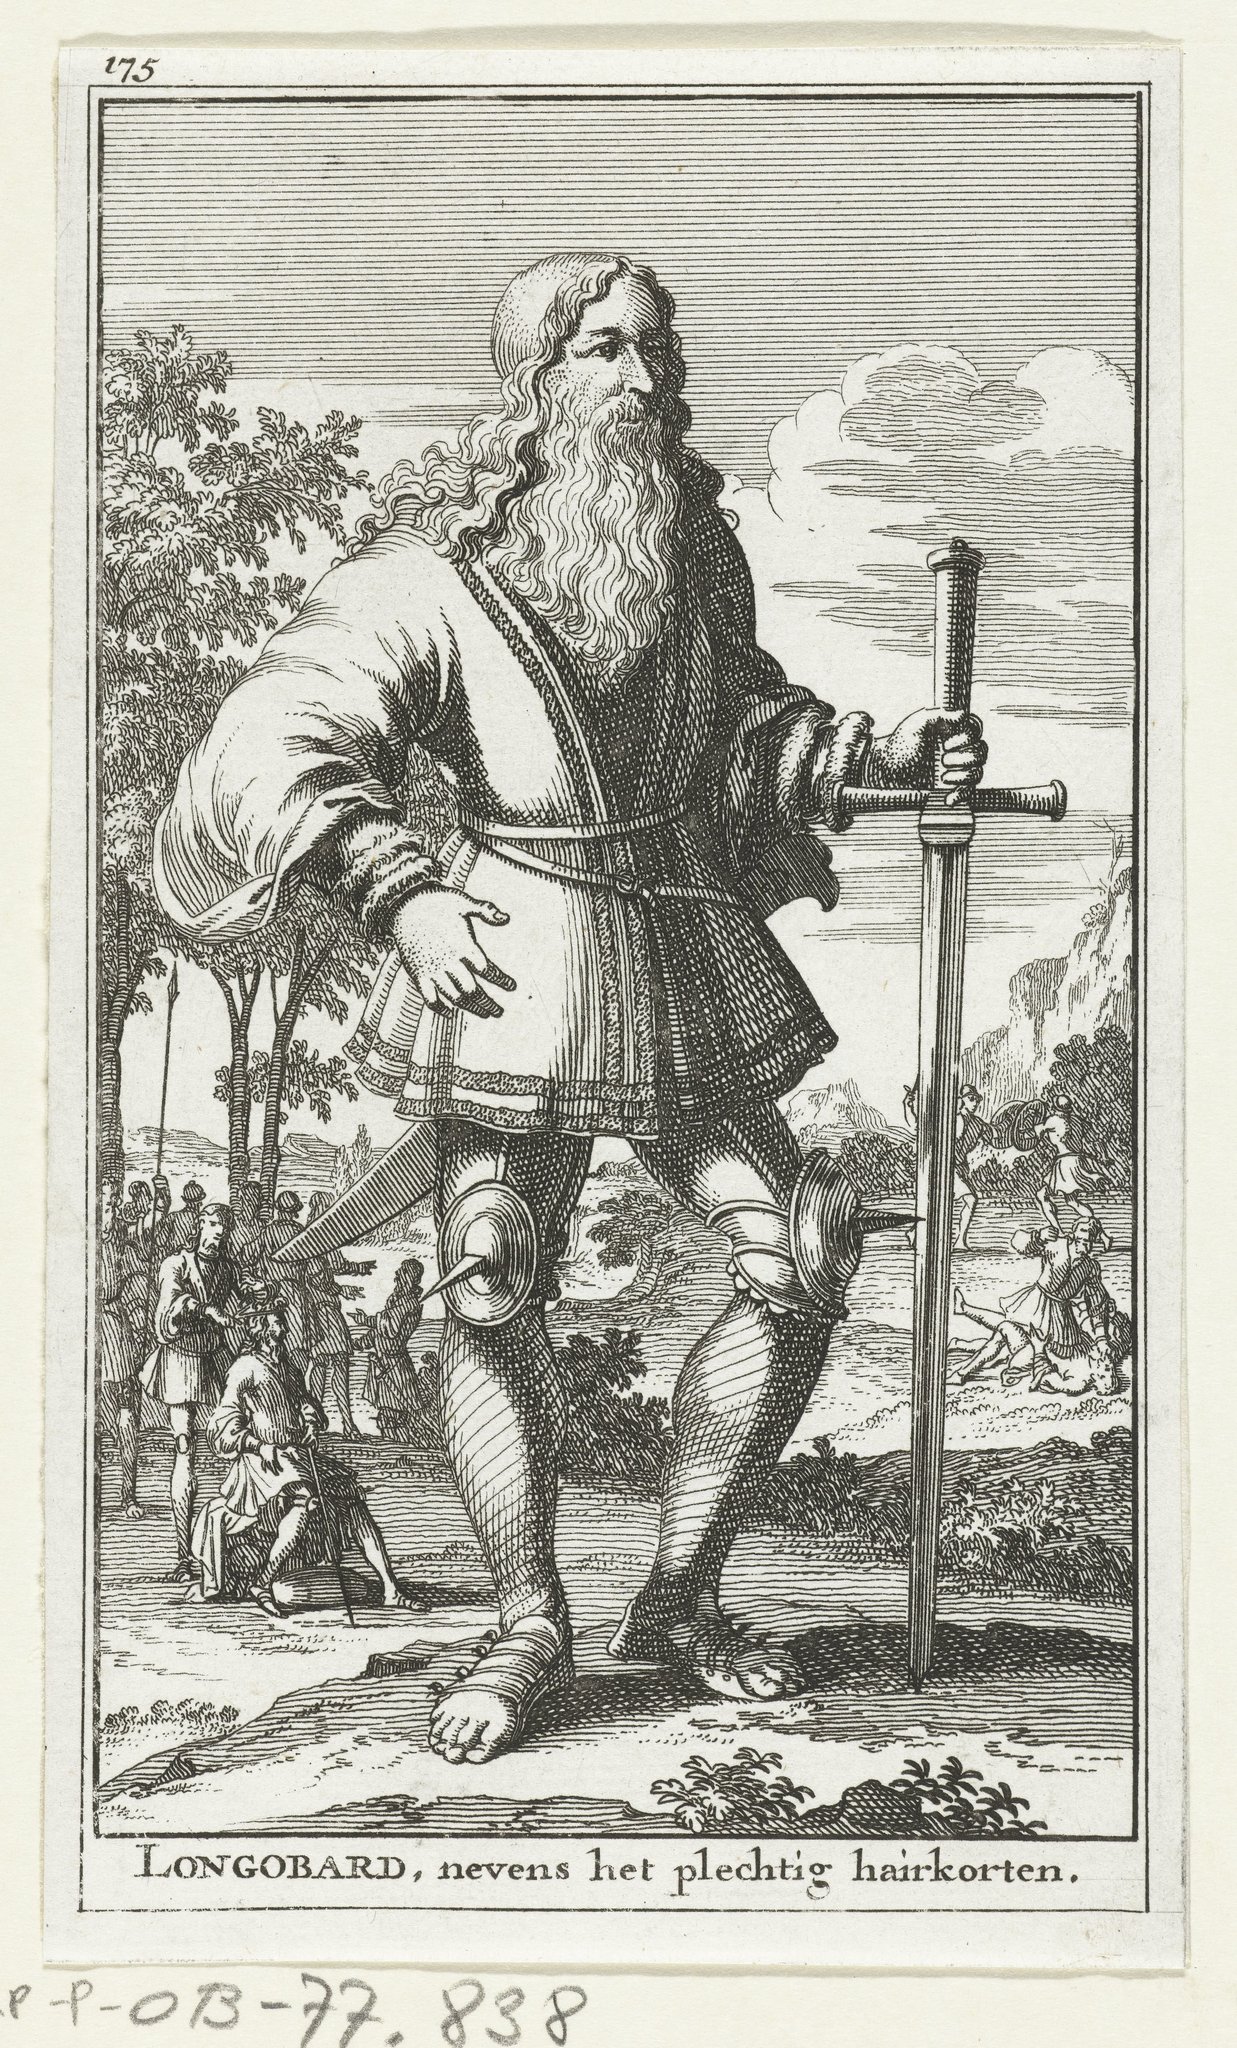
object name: history print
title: Langobard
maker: Anonymous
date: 1712-1714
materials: paper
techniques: etching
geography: netherlands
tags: extinct, 'historical' peoples (lombards), extinct, 'historical' peoples (with name)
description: Gebruikt als illustratie in: Hugo de Groots Antiquitates Germanicæ, of Hoogduitsche oudtheden: waar in de gelegentheid en zeeden der Germaanen, beschreeven door Tacitus, naaukeurig verklaart, en met printverbeeldingen opgeheldert worden: benevens H. Grotius verhandeling van de oudtheid der Batavische republyk. Amsterdam: Jacob van Royen, 1714.